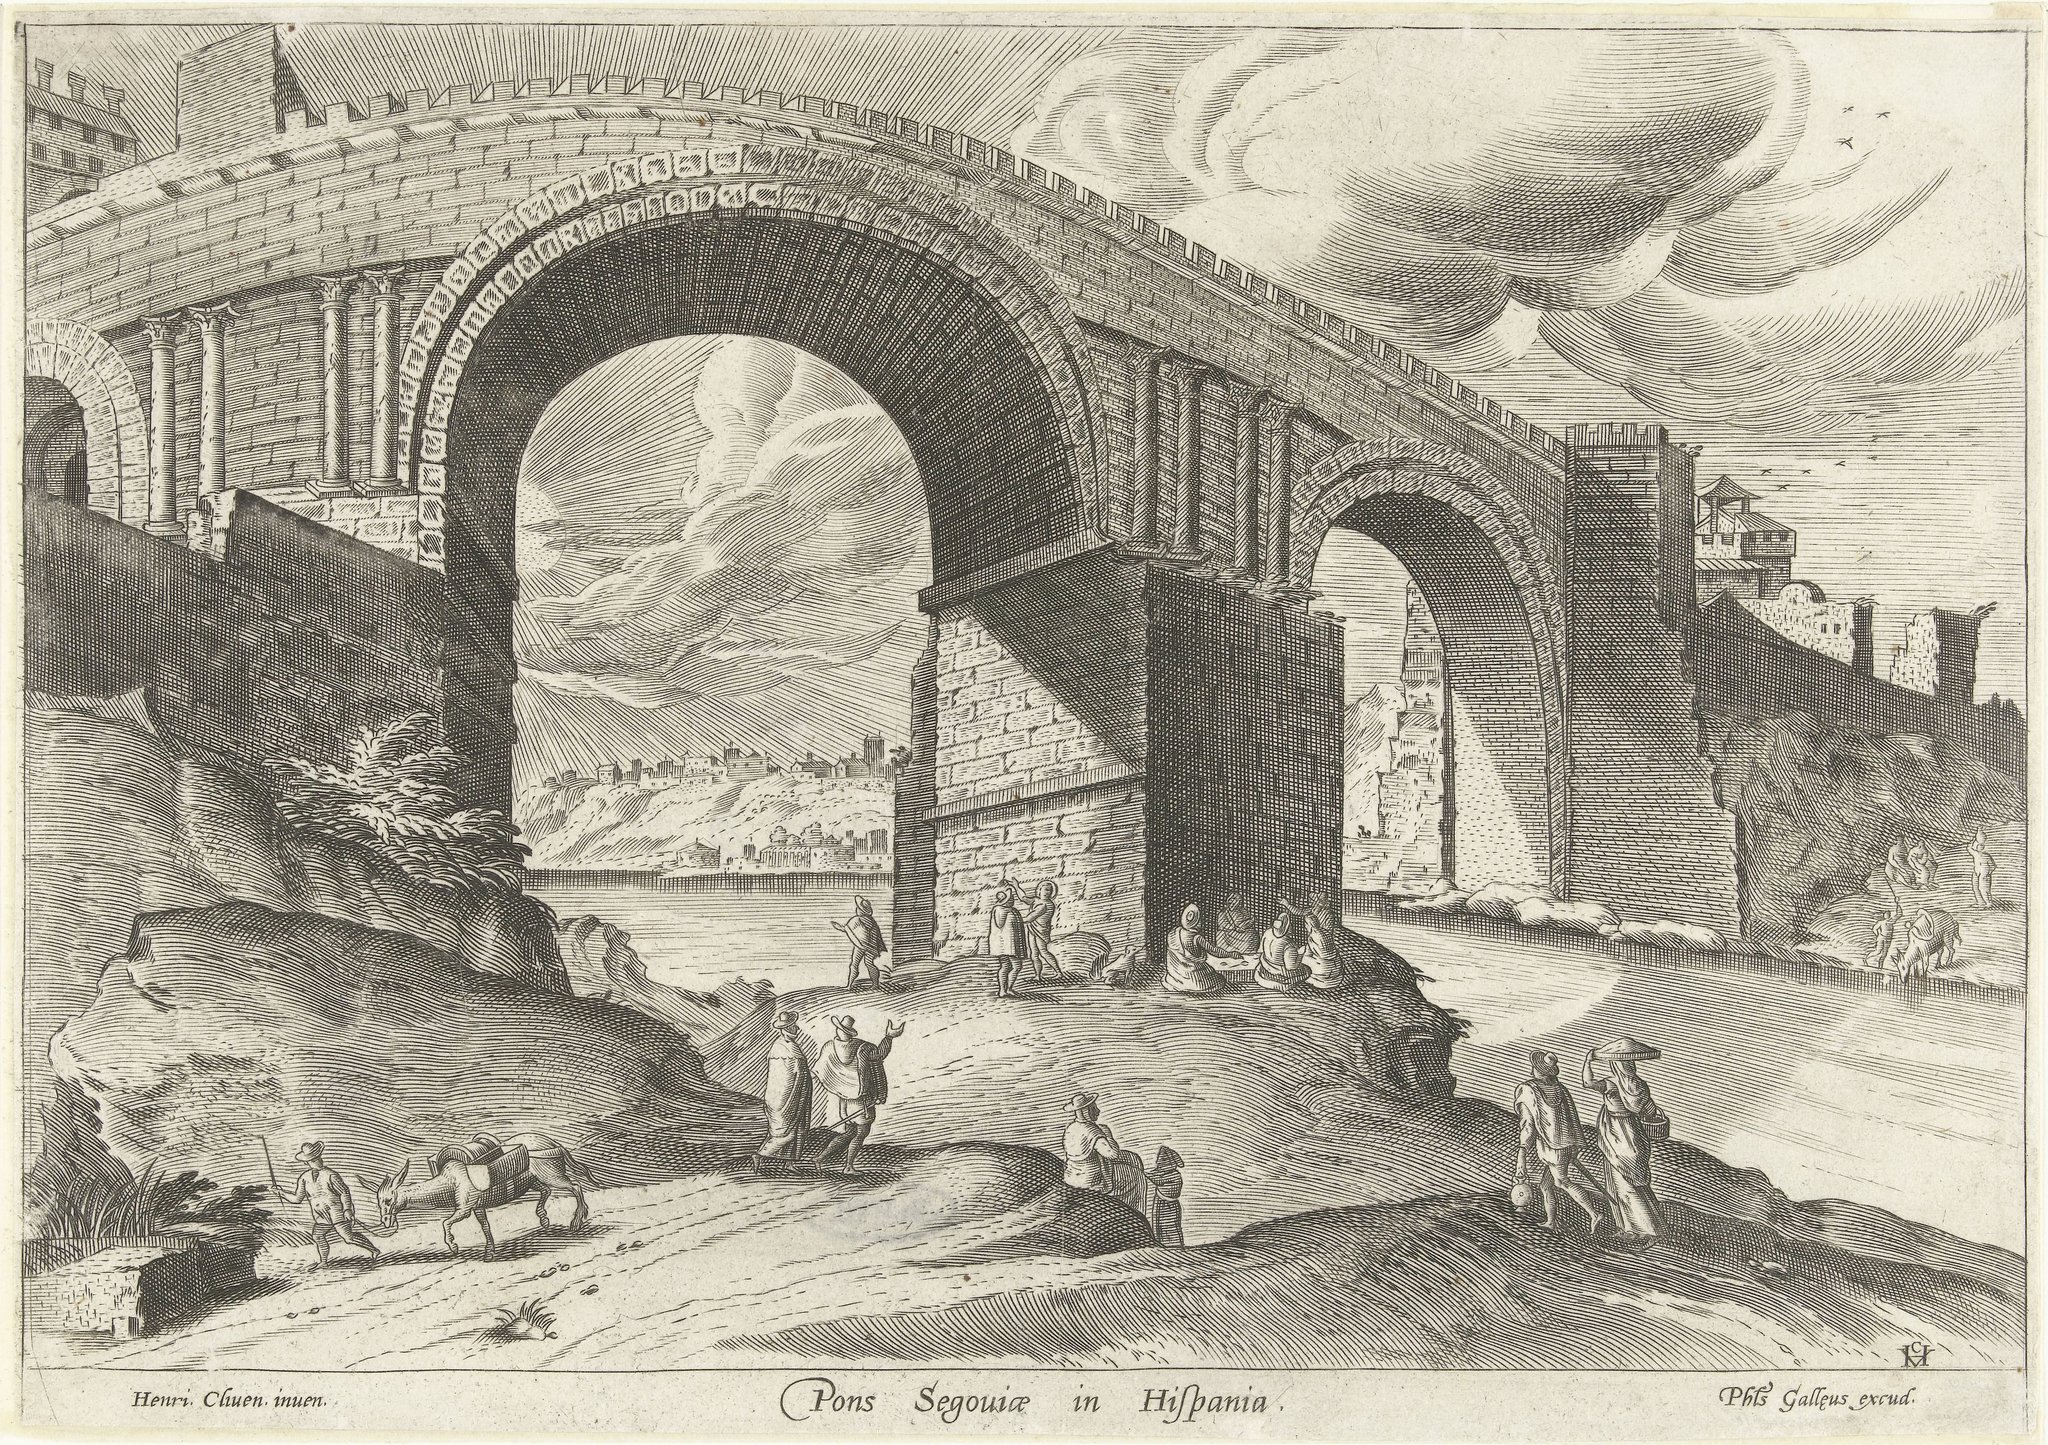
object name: print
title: Gezicht op een brug van de stad Segovia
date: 1585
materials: paper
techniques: engraving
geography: antwerp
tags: landscape with bridge, viaduct or aqueduct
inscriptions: collector's mark: Lugt 2228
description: Gezicht op een brug van de stad Segovia. Onderaan de brug verschillende wandelaars. De prent is deel van een serie die verschillende plaatsen in het Middellandse Zeegebied afbeeldt.